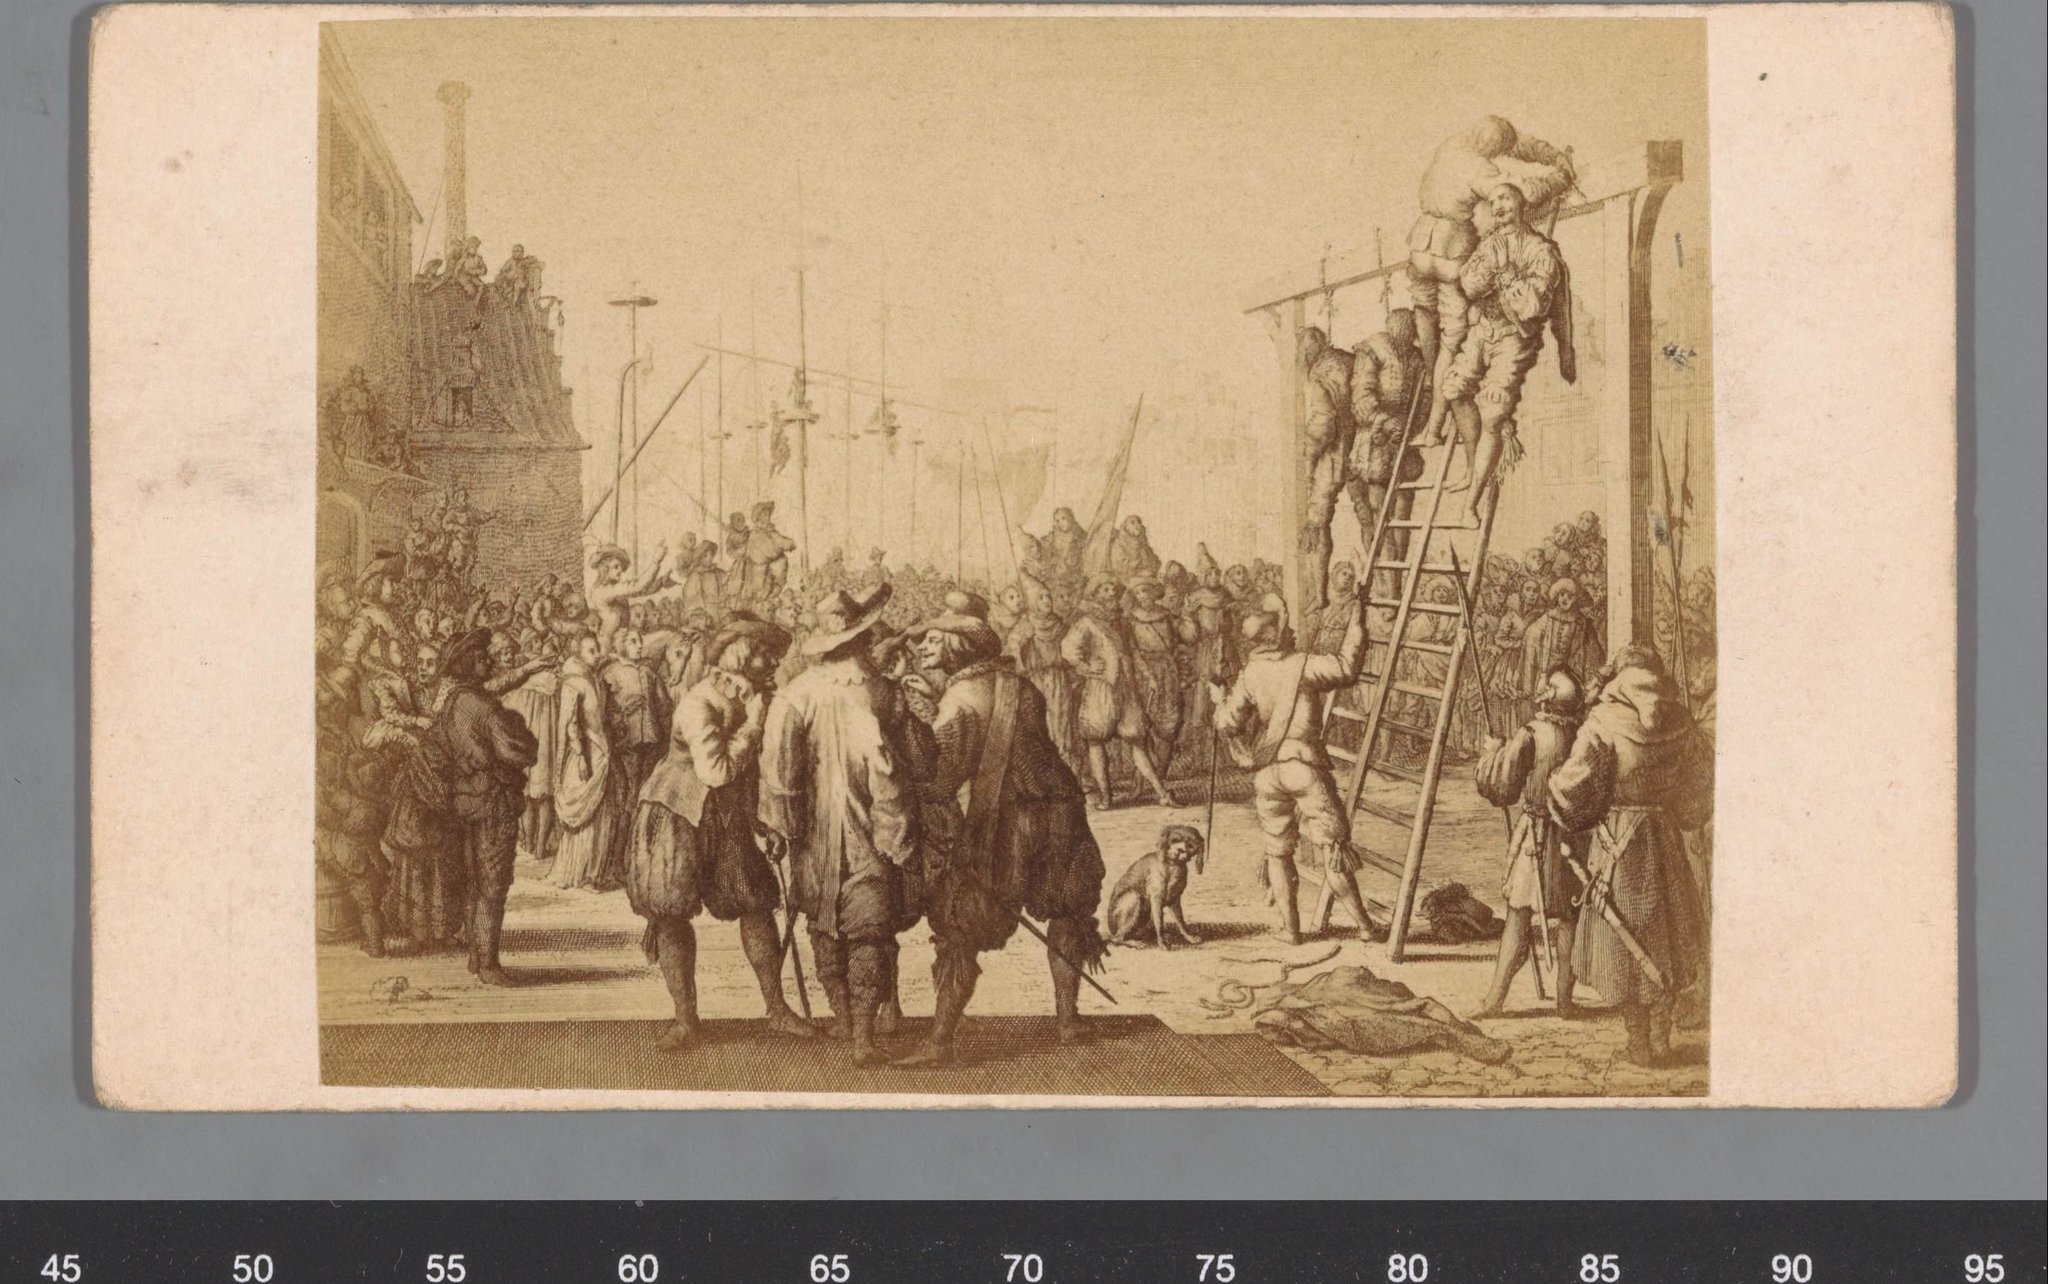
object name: carte de visite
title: Fotoreproductie van een gravure van de ophanging van Don Pedro Pancieco en twee andere Spanjaarden door de Watergeuzen in Vlissingen in 1572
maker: Anonymous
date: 1850-1900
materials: cardboard, photographic support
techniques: albumen print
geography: netherlands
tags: flushing, violent death by hanging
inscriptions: number: ‘21’, inscription: ‘Pacieco en (...) harten uitgedoofd.’, number: ‘21’